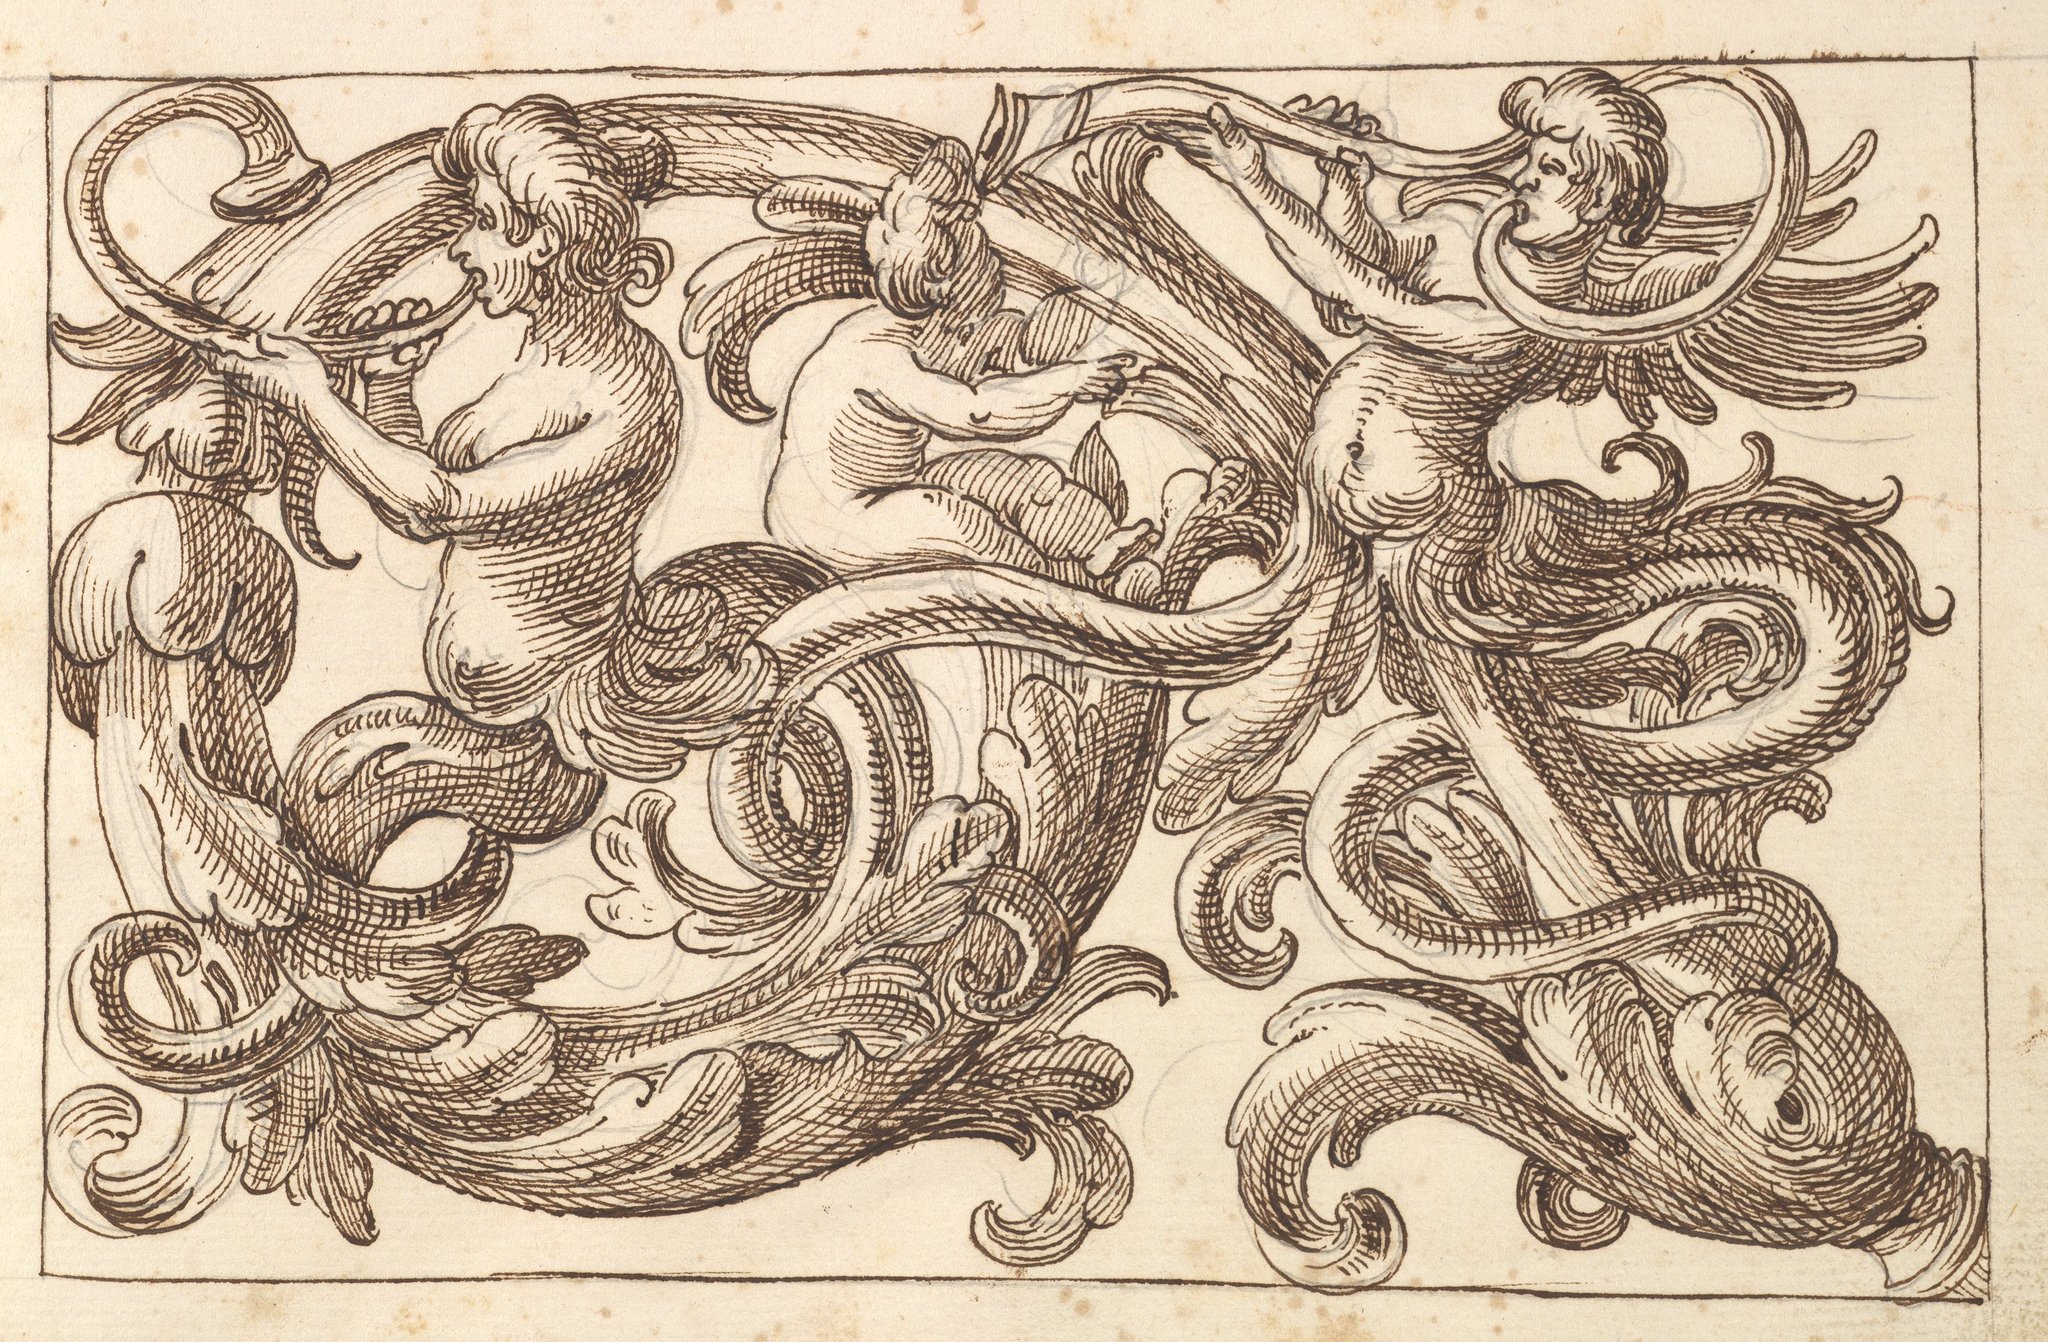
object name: collection ornament architecture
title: Horizontal Panel Design with Two Male Figures and a Putto Interspersed between Acanthus Rinceaux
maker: anonymous, italian, venetian, 17th century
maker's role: artist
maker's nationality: italian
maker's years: 1600-1700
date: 1601-1700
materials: ink, drawing material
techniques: pen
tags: musical instruments,men,mythical creatures,acanthus